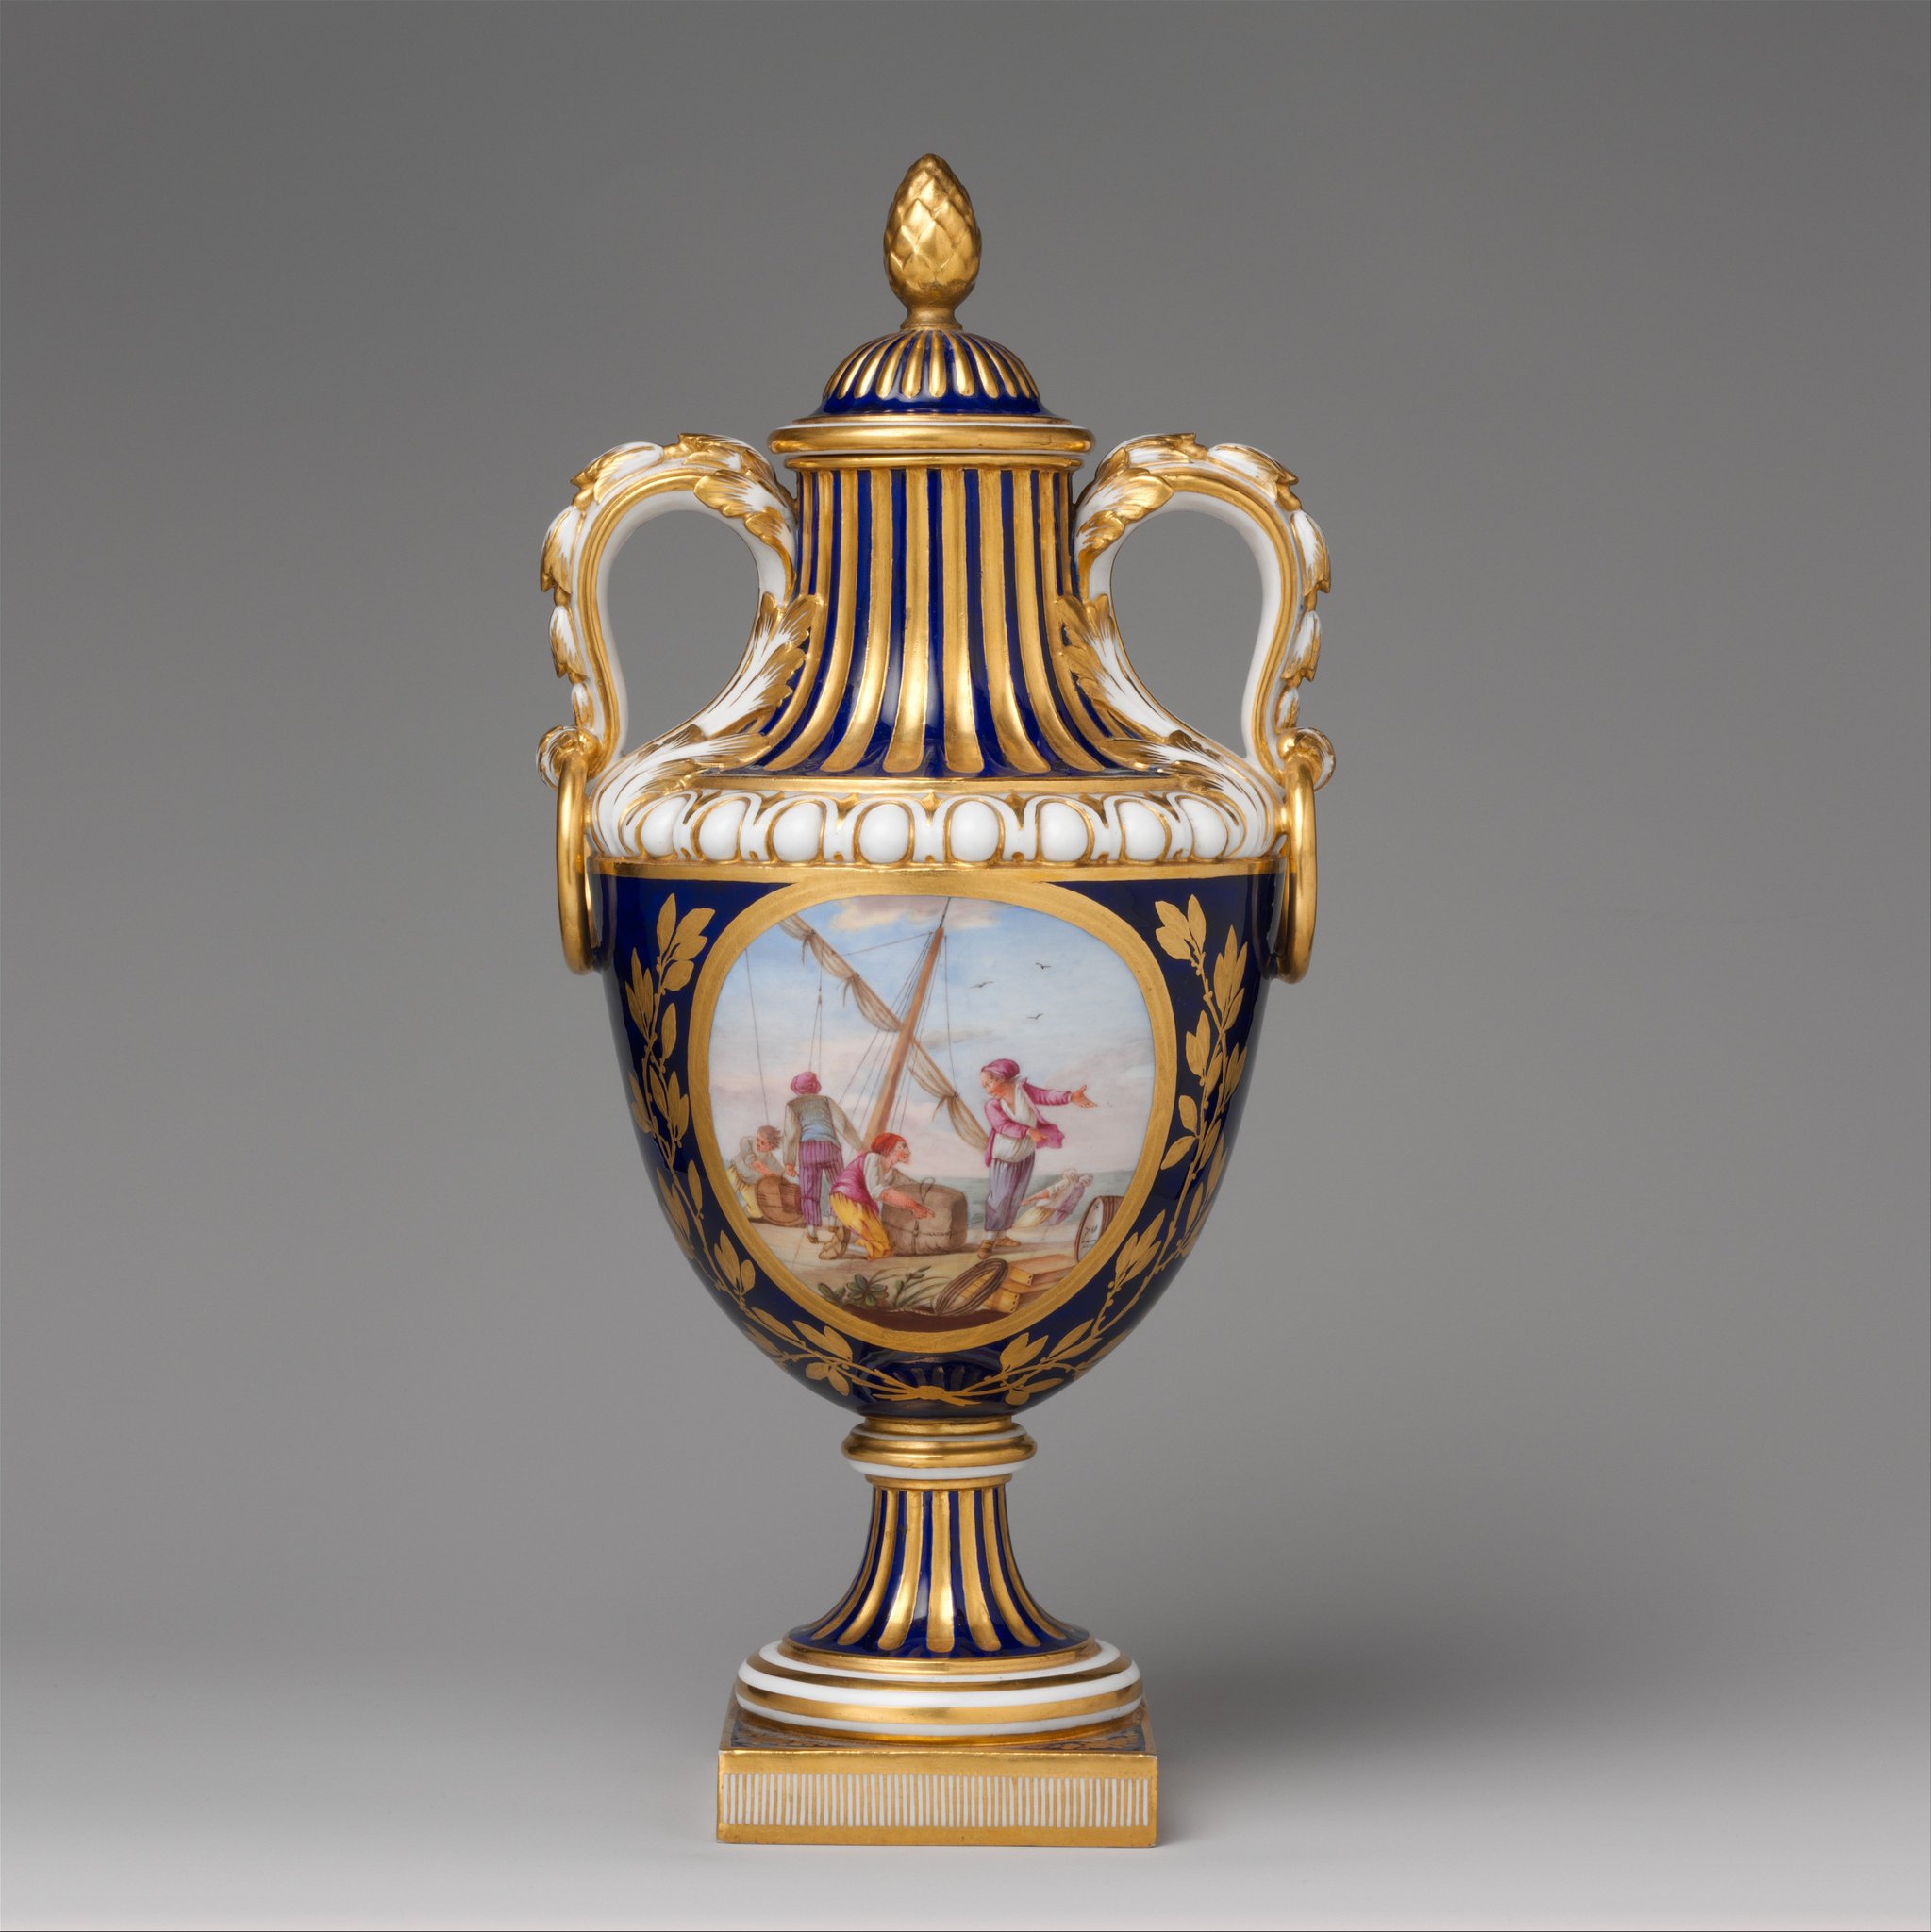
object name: vase with cover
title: Vase with cover (vase de coté de Paris) (one of a pair)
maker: sèvres manufactory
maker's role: manufactory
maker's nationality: french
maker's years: 1740-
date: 1775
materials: soft paste porcelain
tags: men